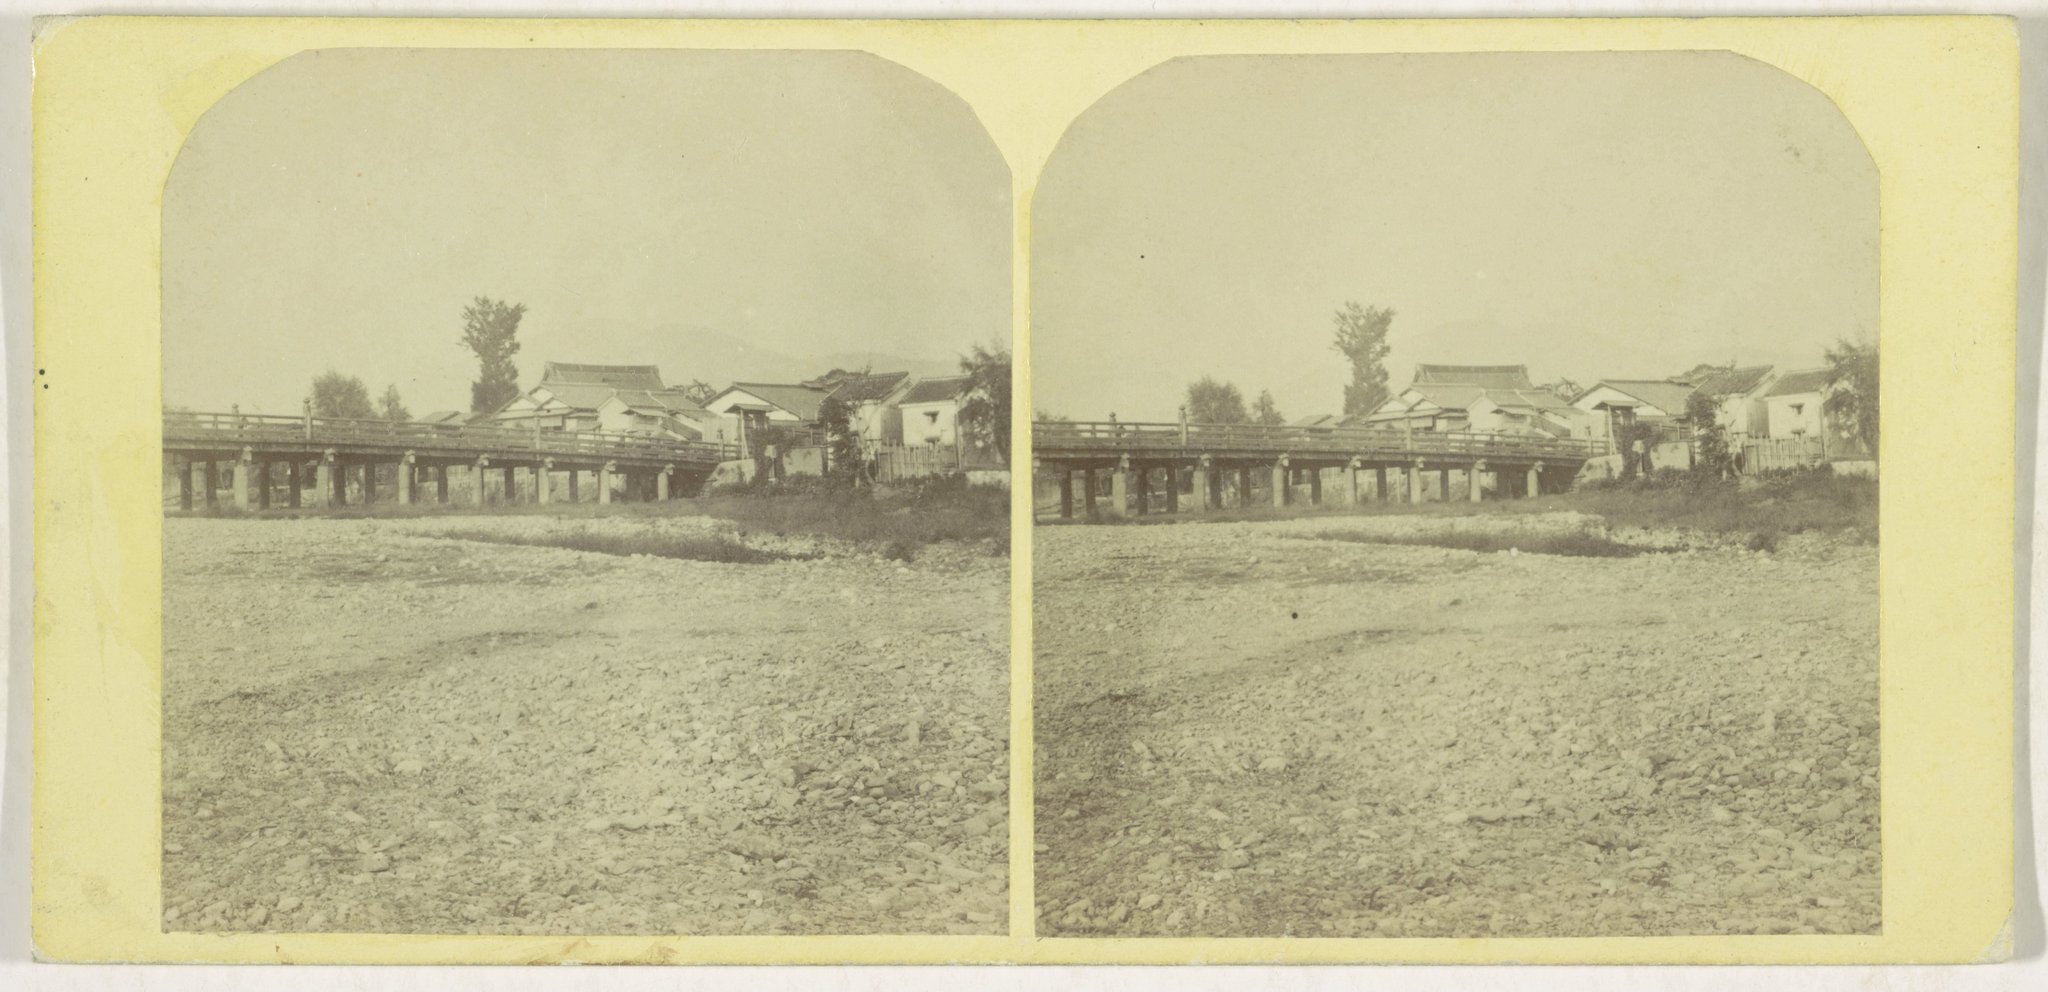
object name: photograph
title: Opgedroogde rivier te Japan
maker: Anonymous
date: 1861-1870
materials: cardboard, paper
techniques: albumen print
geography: japan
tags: dry river, river bed, japan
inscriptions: inscription: ‘Godjoo kaihi [?]’